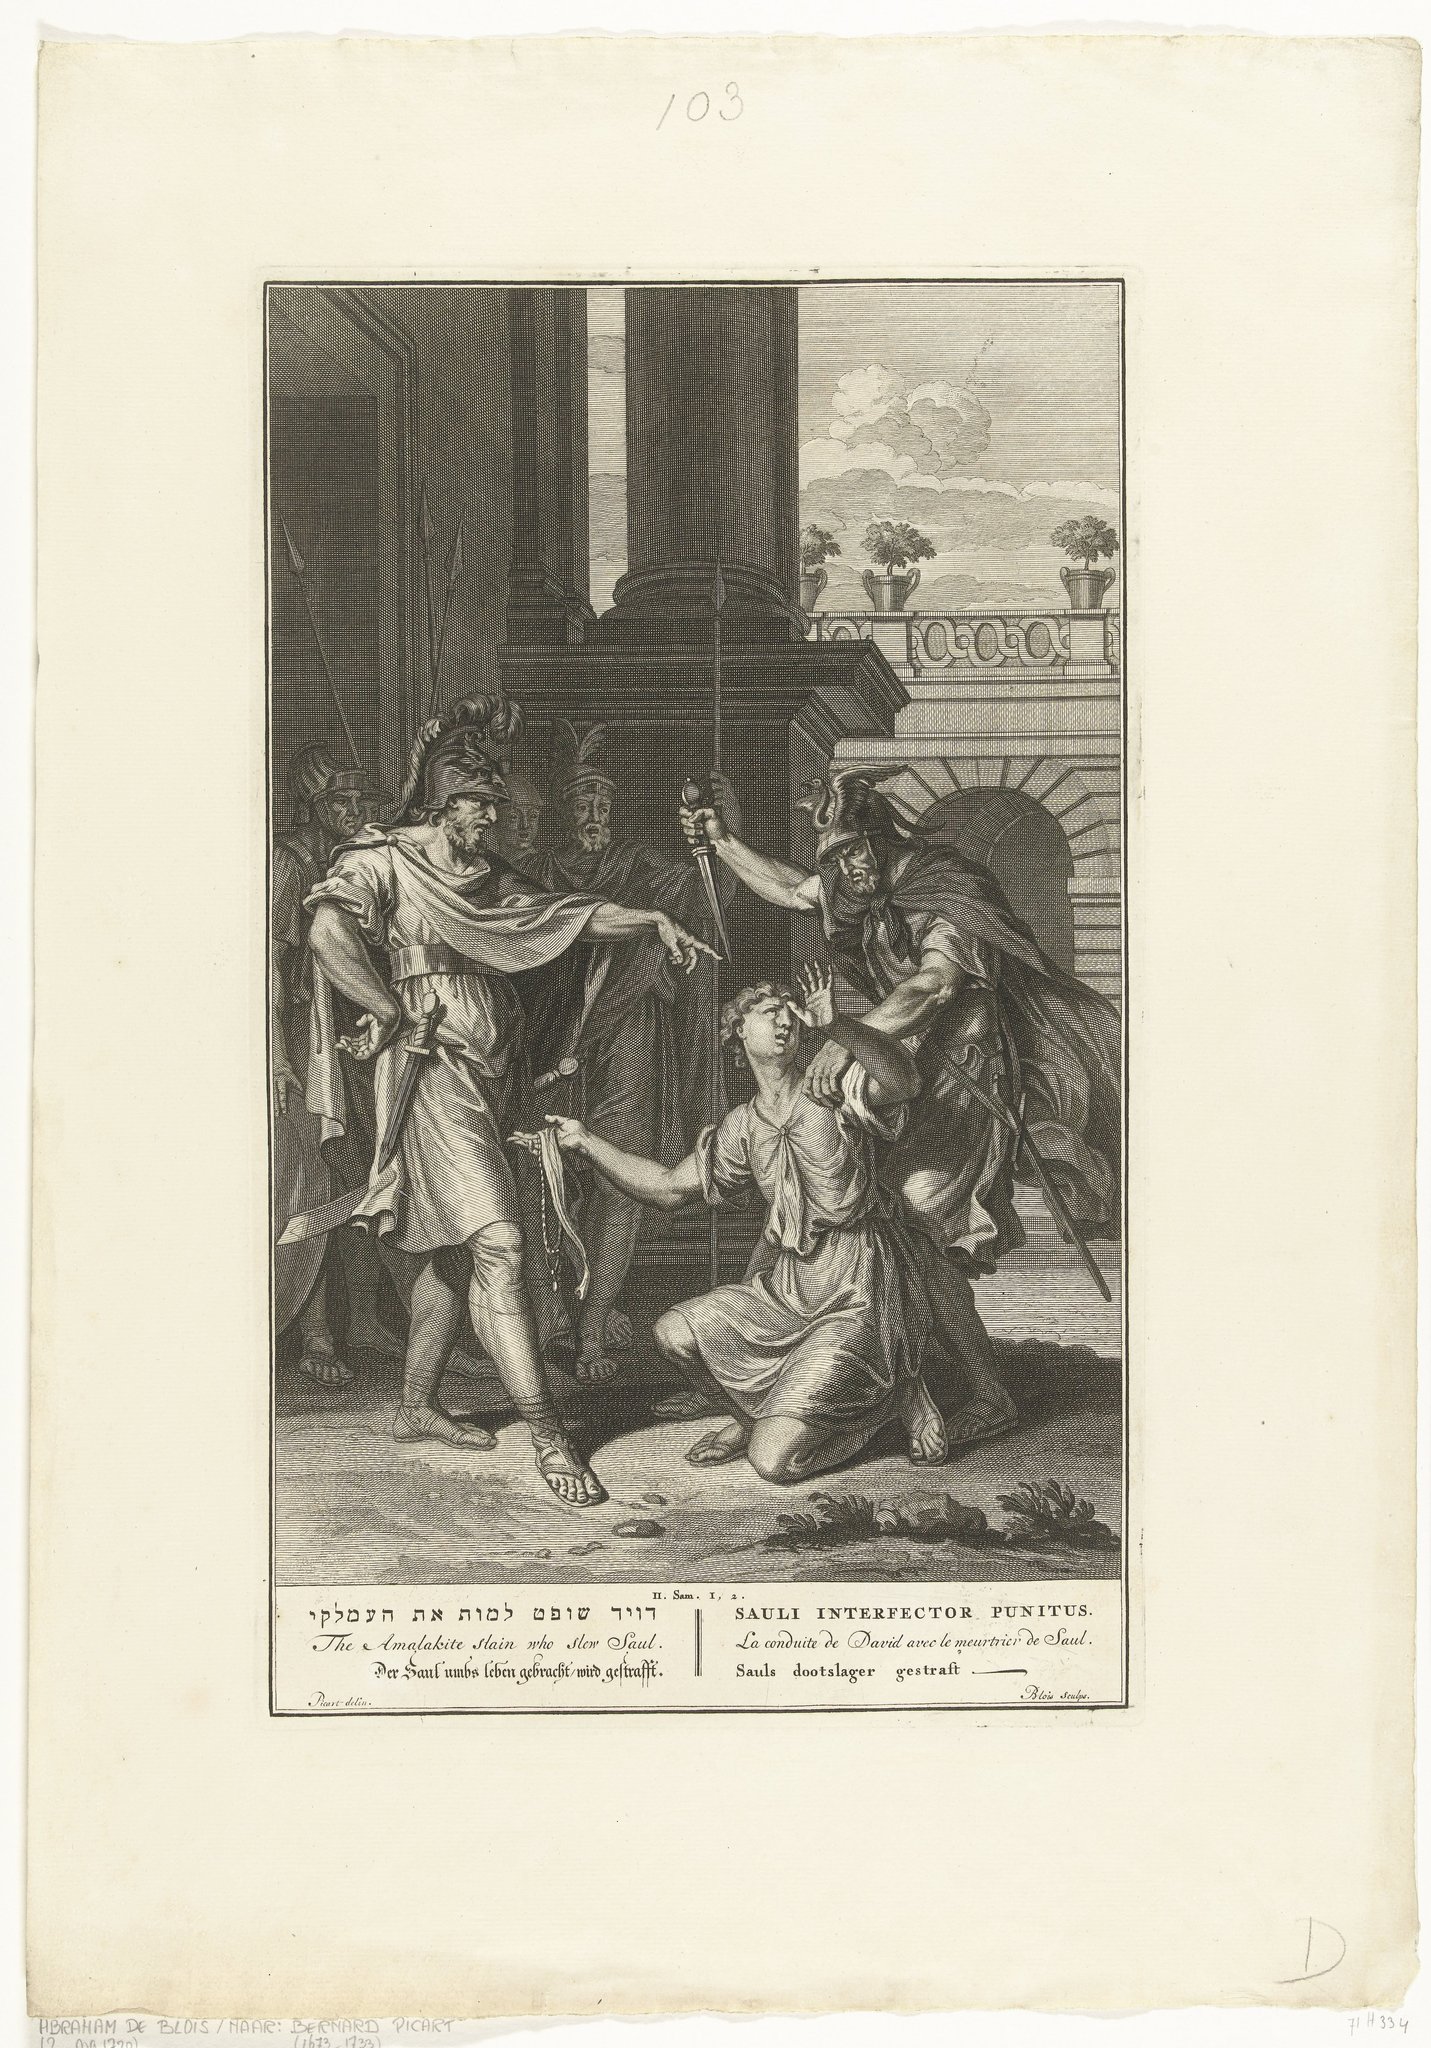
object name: print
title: Sauls dootslager gestraft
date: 1679-1717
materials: paper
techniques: engraving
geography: amsterdam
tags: the messenger who brought david the message of saul's death is put to death by one of david's soldiers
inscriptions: collector's mark: Lugt 2228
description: Prent voor: Hoet, Gerard, Taferelen der voornaamste geschiedenissen van het Oude en Nieuwe Testament, en andere boeken, bij de Heilige Schrift gevoegt, door Hoet, Houbraken, en Picart getekent en van de beste meesters in koper gesneden en met beschrijvingen uitgebreid, 3 delen, 's-Gravenhage, Pieter de Hondt, 1728